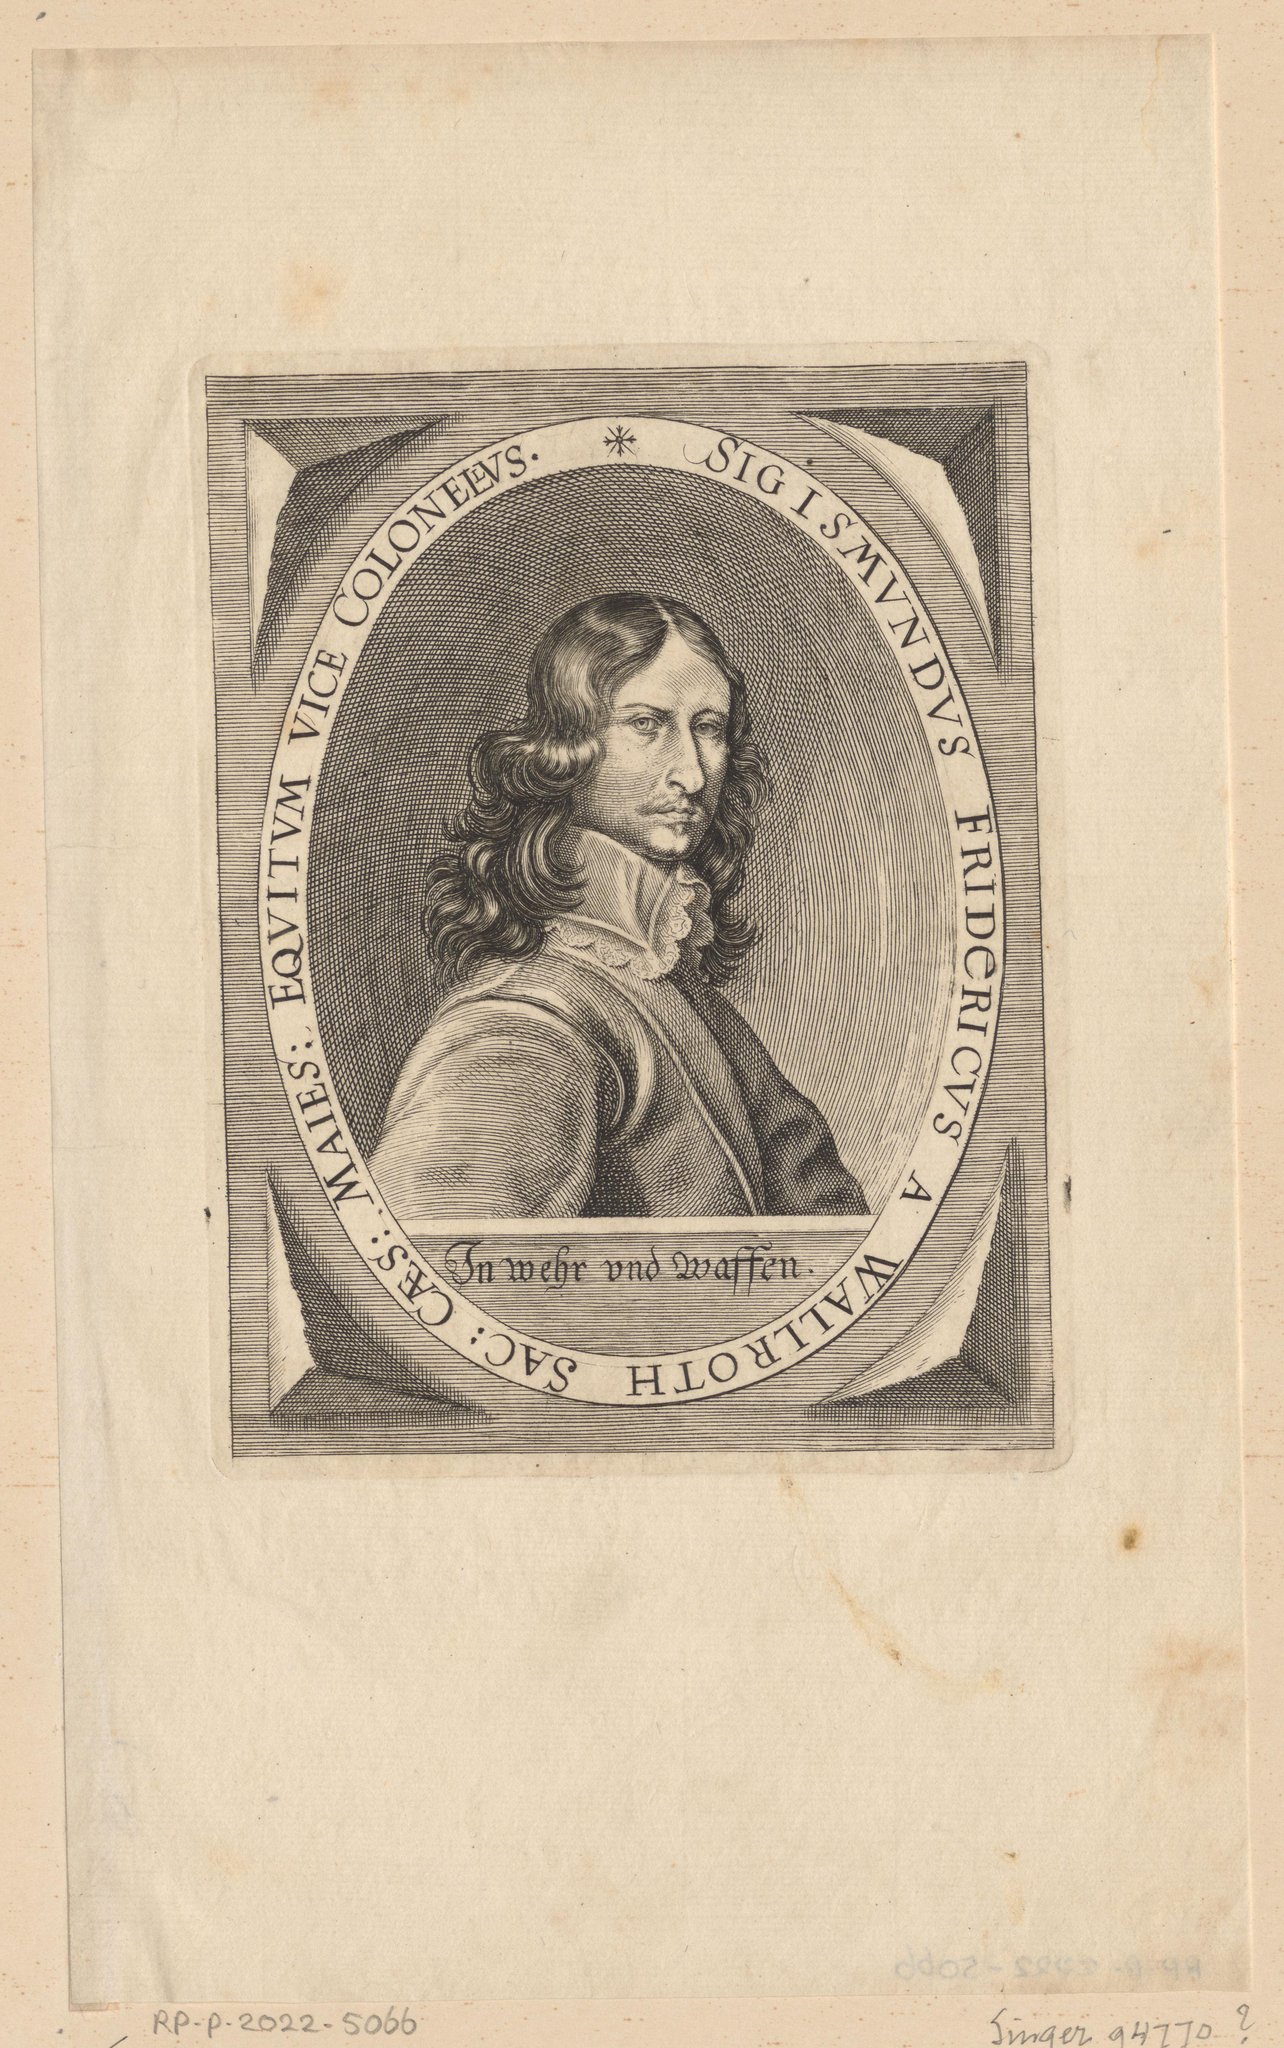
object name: print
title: Portret van Sigismund Friedrich von Wallroth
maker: elias widemann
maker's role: print maker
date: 1649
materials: paper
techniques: engraving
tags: historical persons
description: Prent uit de publicatie: Widemann, Elias. Honori Sacrum. Wenen: s.n., 1649.